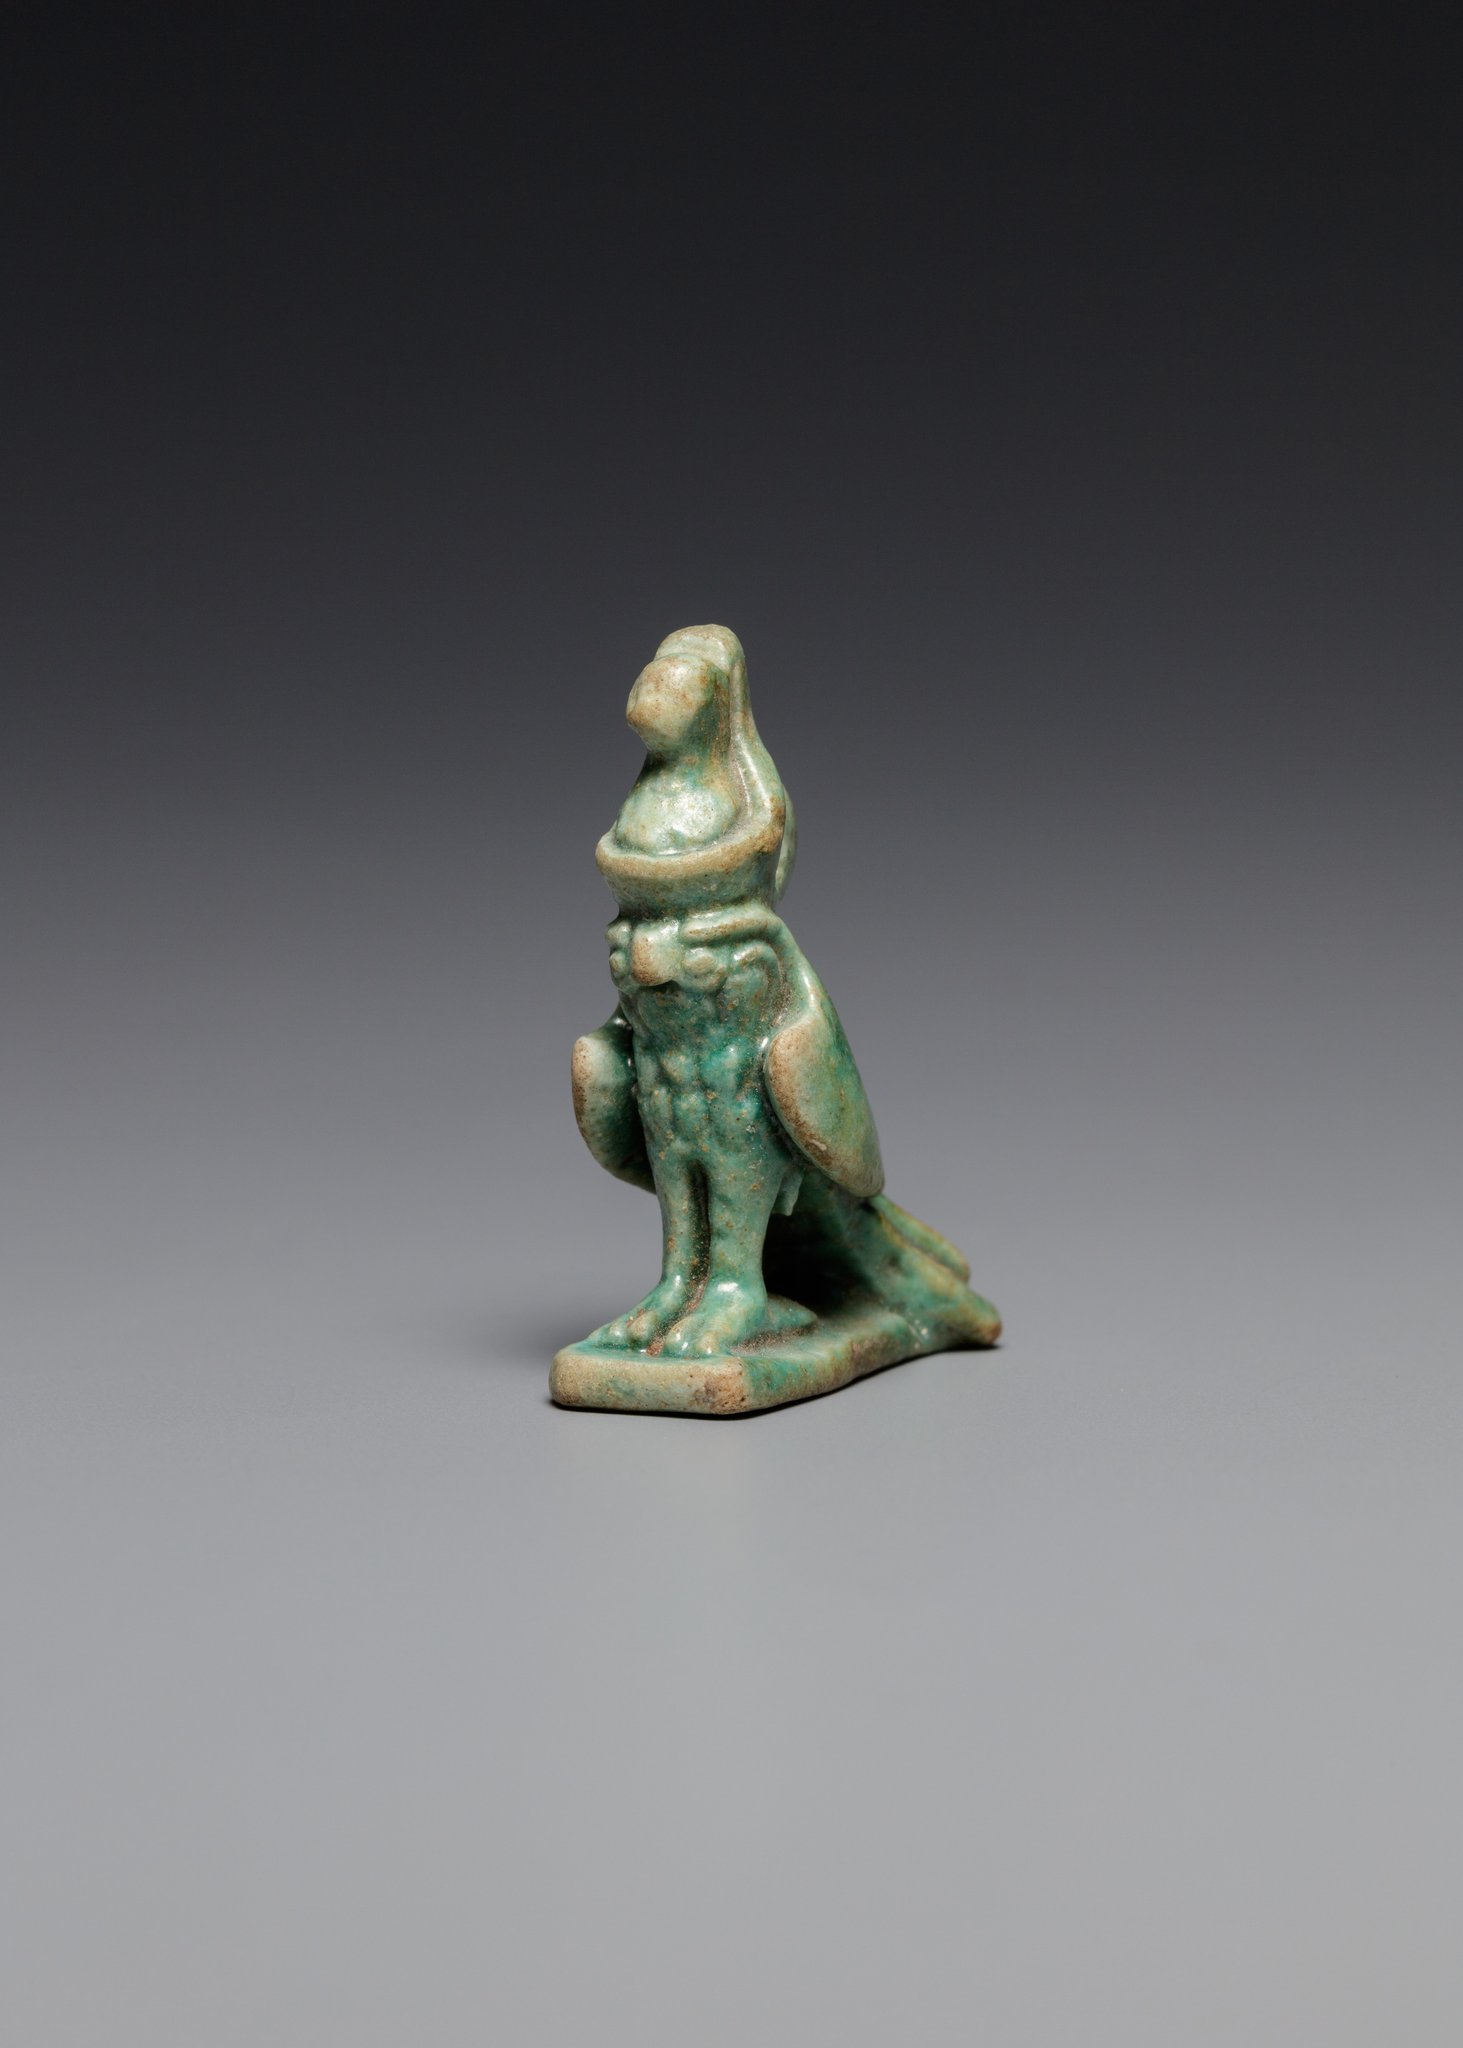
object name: amulet, horus falcon, double crown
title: Horus falcon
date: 664-332 BCE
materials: faience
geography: egypt